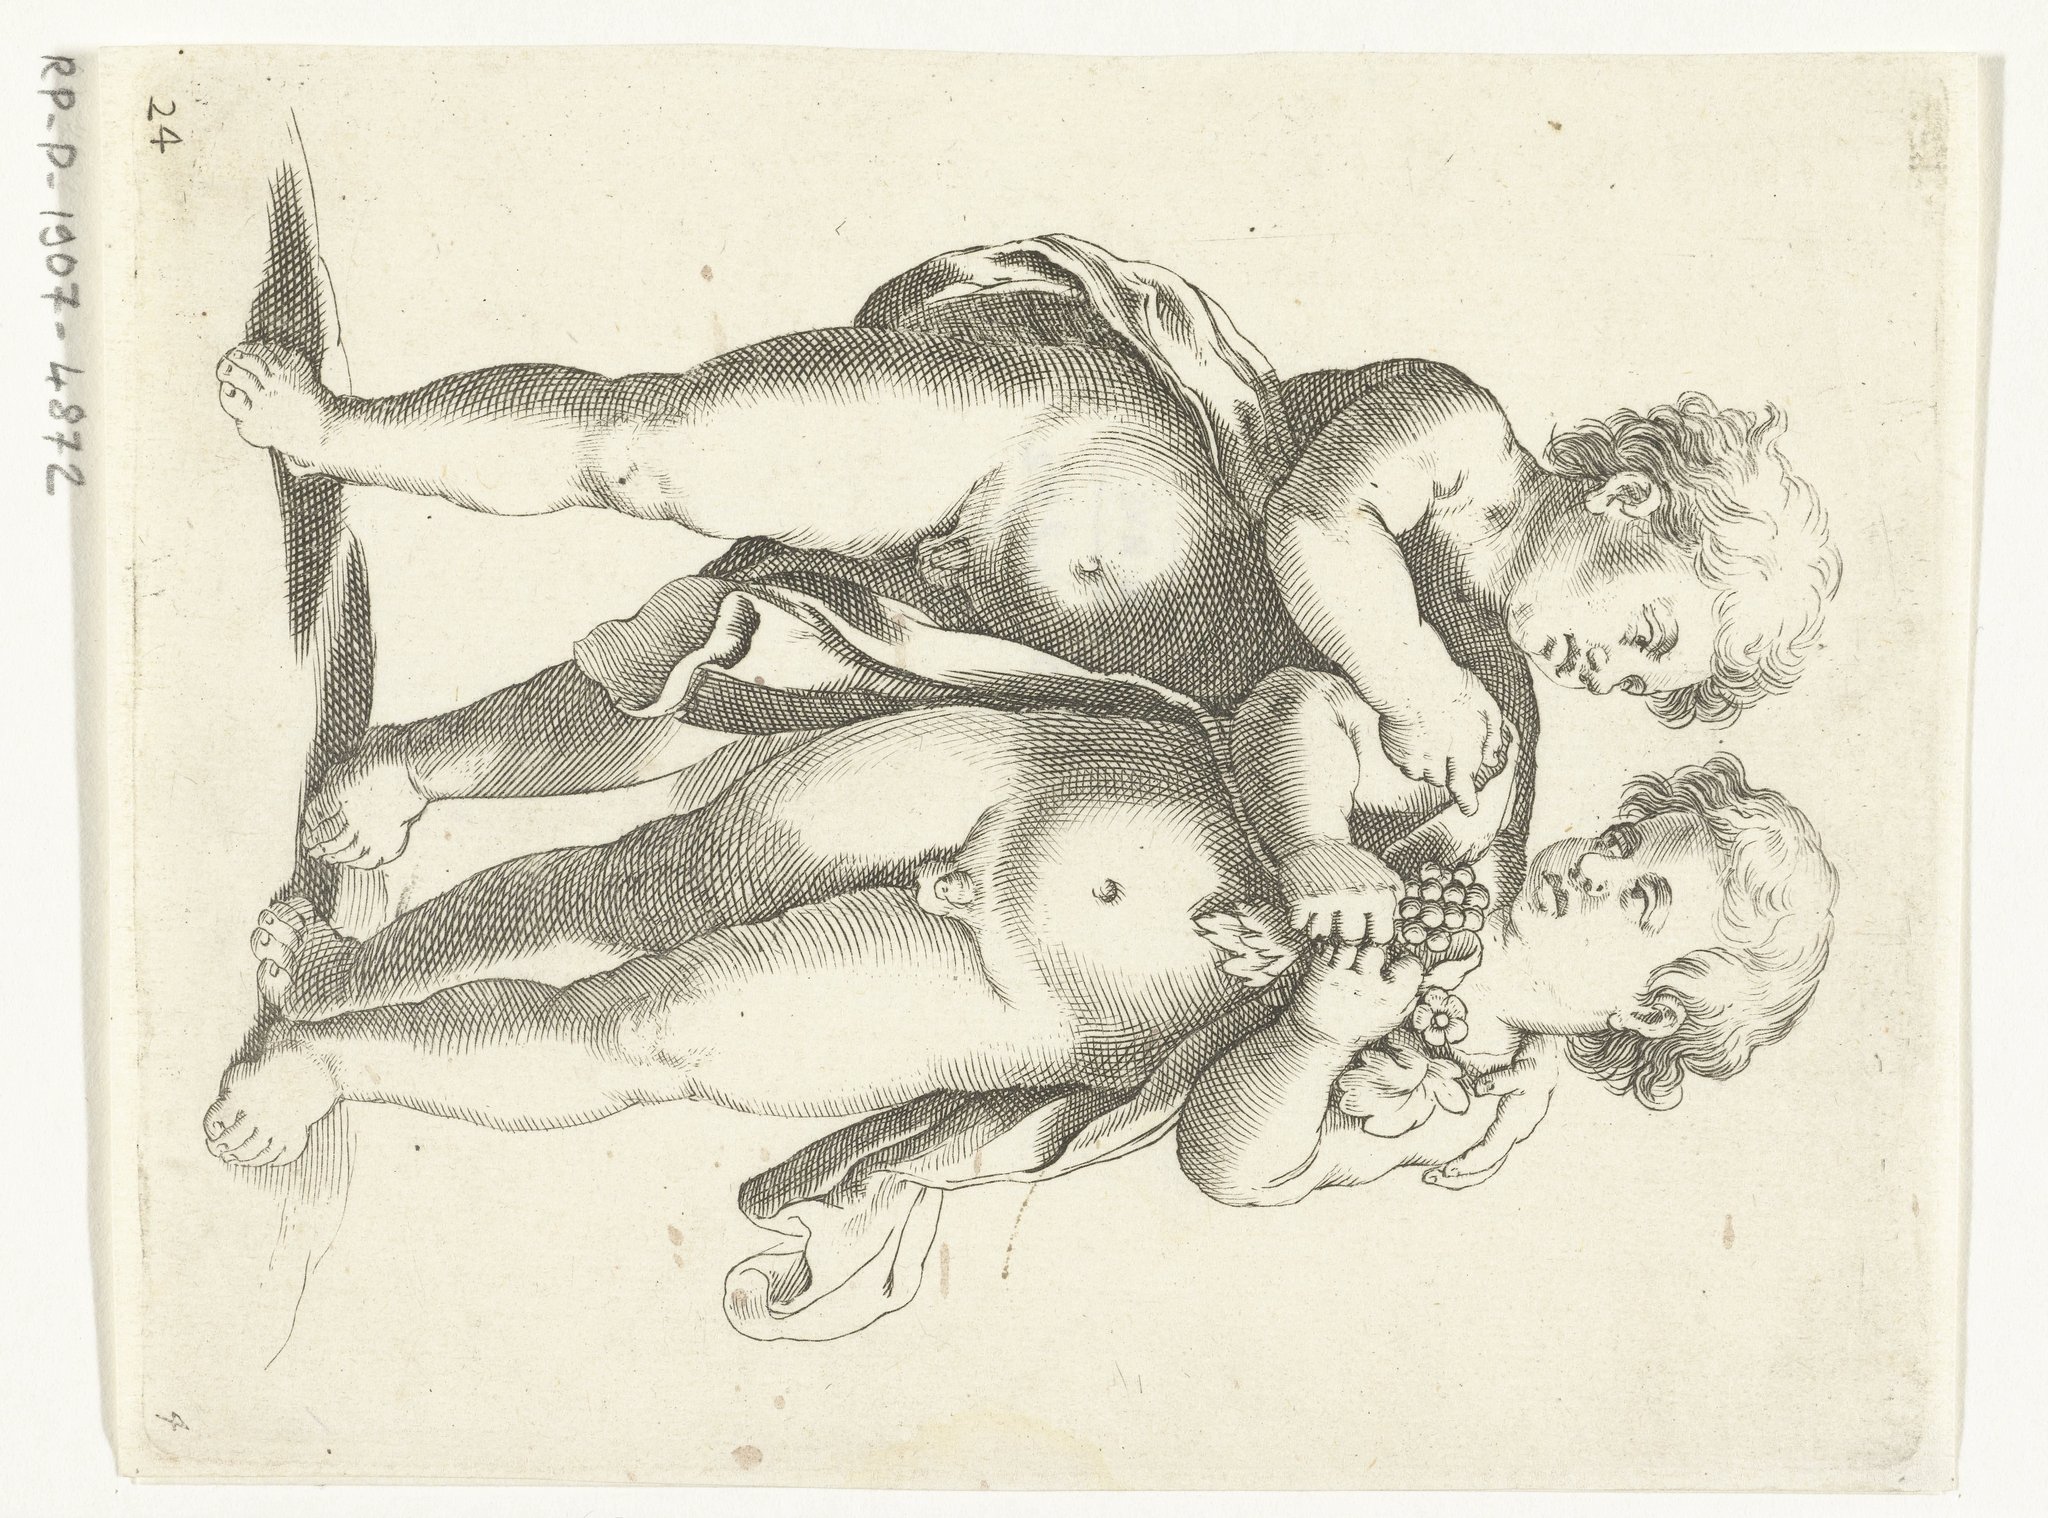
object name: print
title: Twee putti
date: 1671-1726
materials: paper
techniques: engraving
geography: amsterdam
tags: cupids: 'amores', 'amoretti', 'putti'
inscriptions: collector's mark: Lugt 2228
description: Twee staande putti waarvan de ene de andere een doek om de schouders legt. Afkomstig uit "Nieuw teecken-boeck. Tweede deel" uitgegeven door G. Valck. Linksonder genummerd 24.